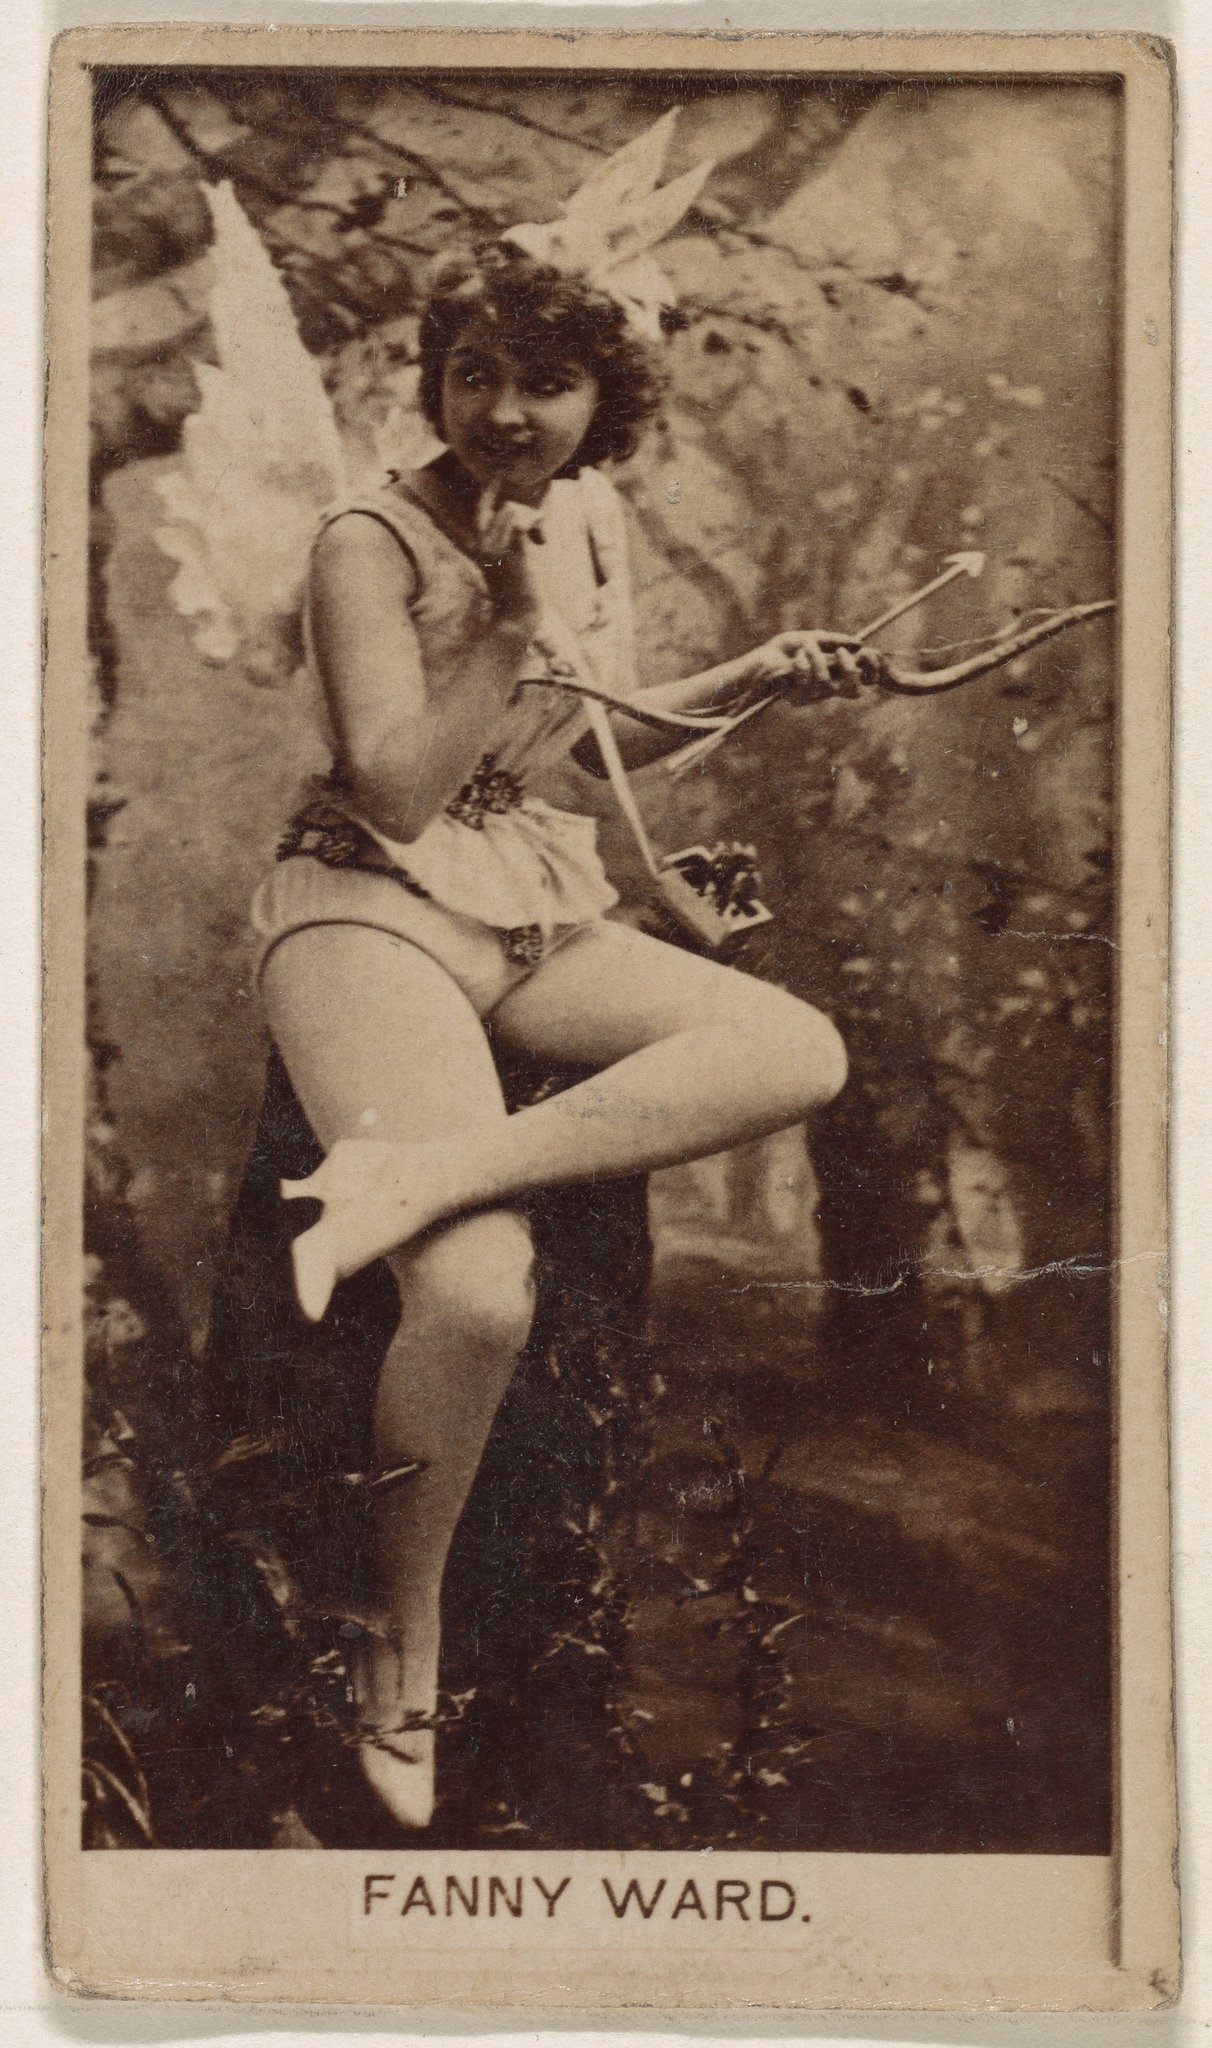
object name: photograph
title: Fanny Ward, from the Actresses series (N245) issued by Kinney Brothers to promote Sweet Caporal Cigarettes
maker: kinney brothers tobacco company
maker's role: publisher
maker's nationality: american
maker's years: 1869-2011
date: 1890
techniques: albumen silver print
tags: portraits,women,actresses